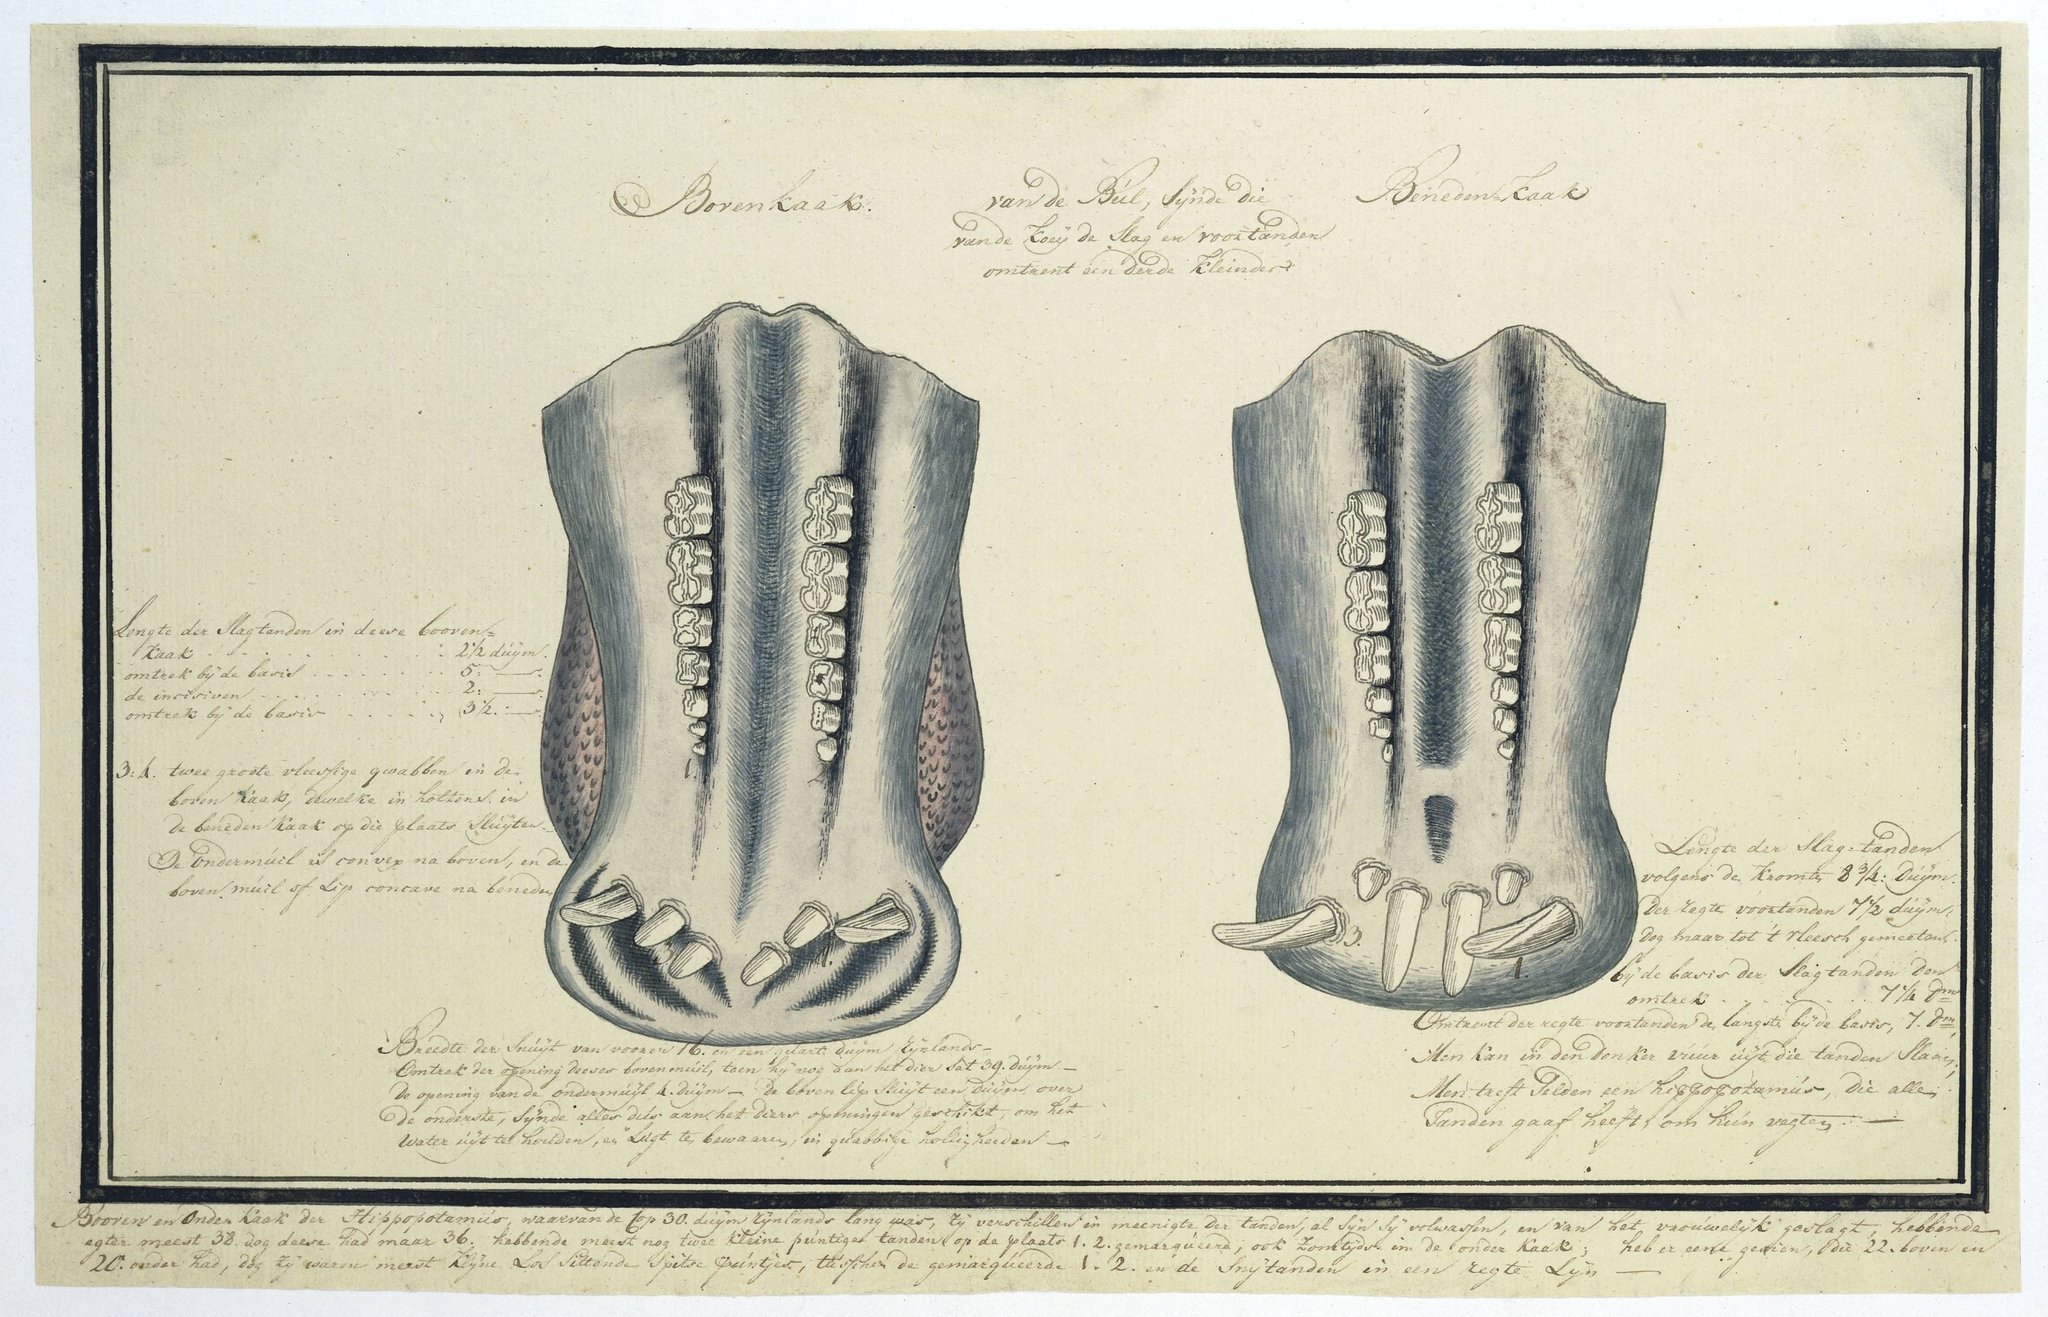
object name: drawing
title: Upper and lower jaws of an Hippopotamus amphibius (Hippopotamus)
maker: robert jacob gordon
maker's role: draughtsman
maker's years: 1743-1795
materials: chalk, ink, paper, pencil, watercolor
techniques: brush, pen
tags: hoofed animals: hippopotamus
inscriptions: annotation: ‘boven, links: Bovenkaak, rechts: Benedenkaak; daartussen stuk tekst, evenals naast en onder de afbeeldingen; onderin de marge: Booven en Onderkaak der Hippopotamus, {...]’